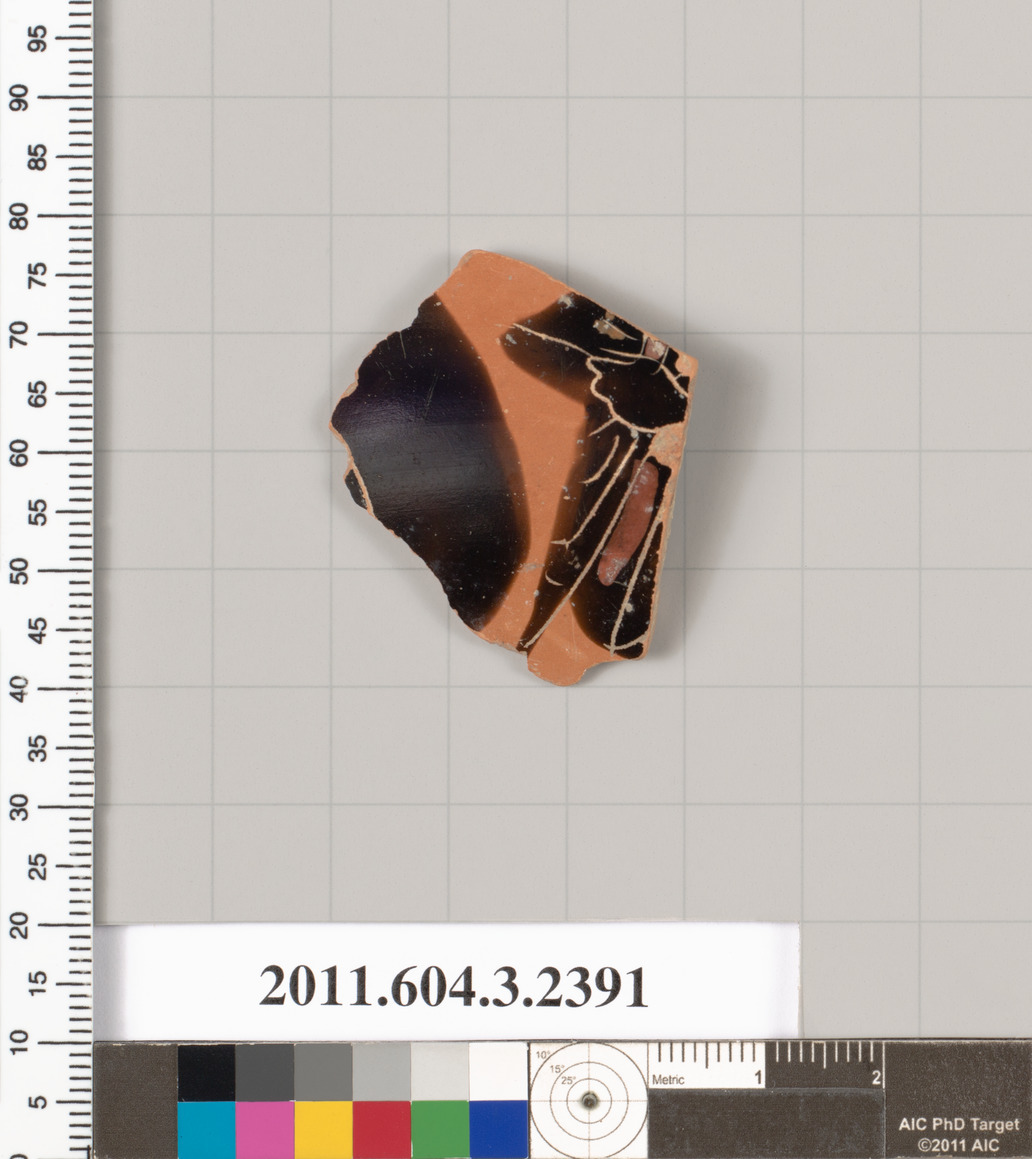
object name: kylix fragment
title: Terracotta fragment of a kylix: eye-cup (drinking cup)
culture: greek, attic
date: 525-501 BCE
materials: terracotta